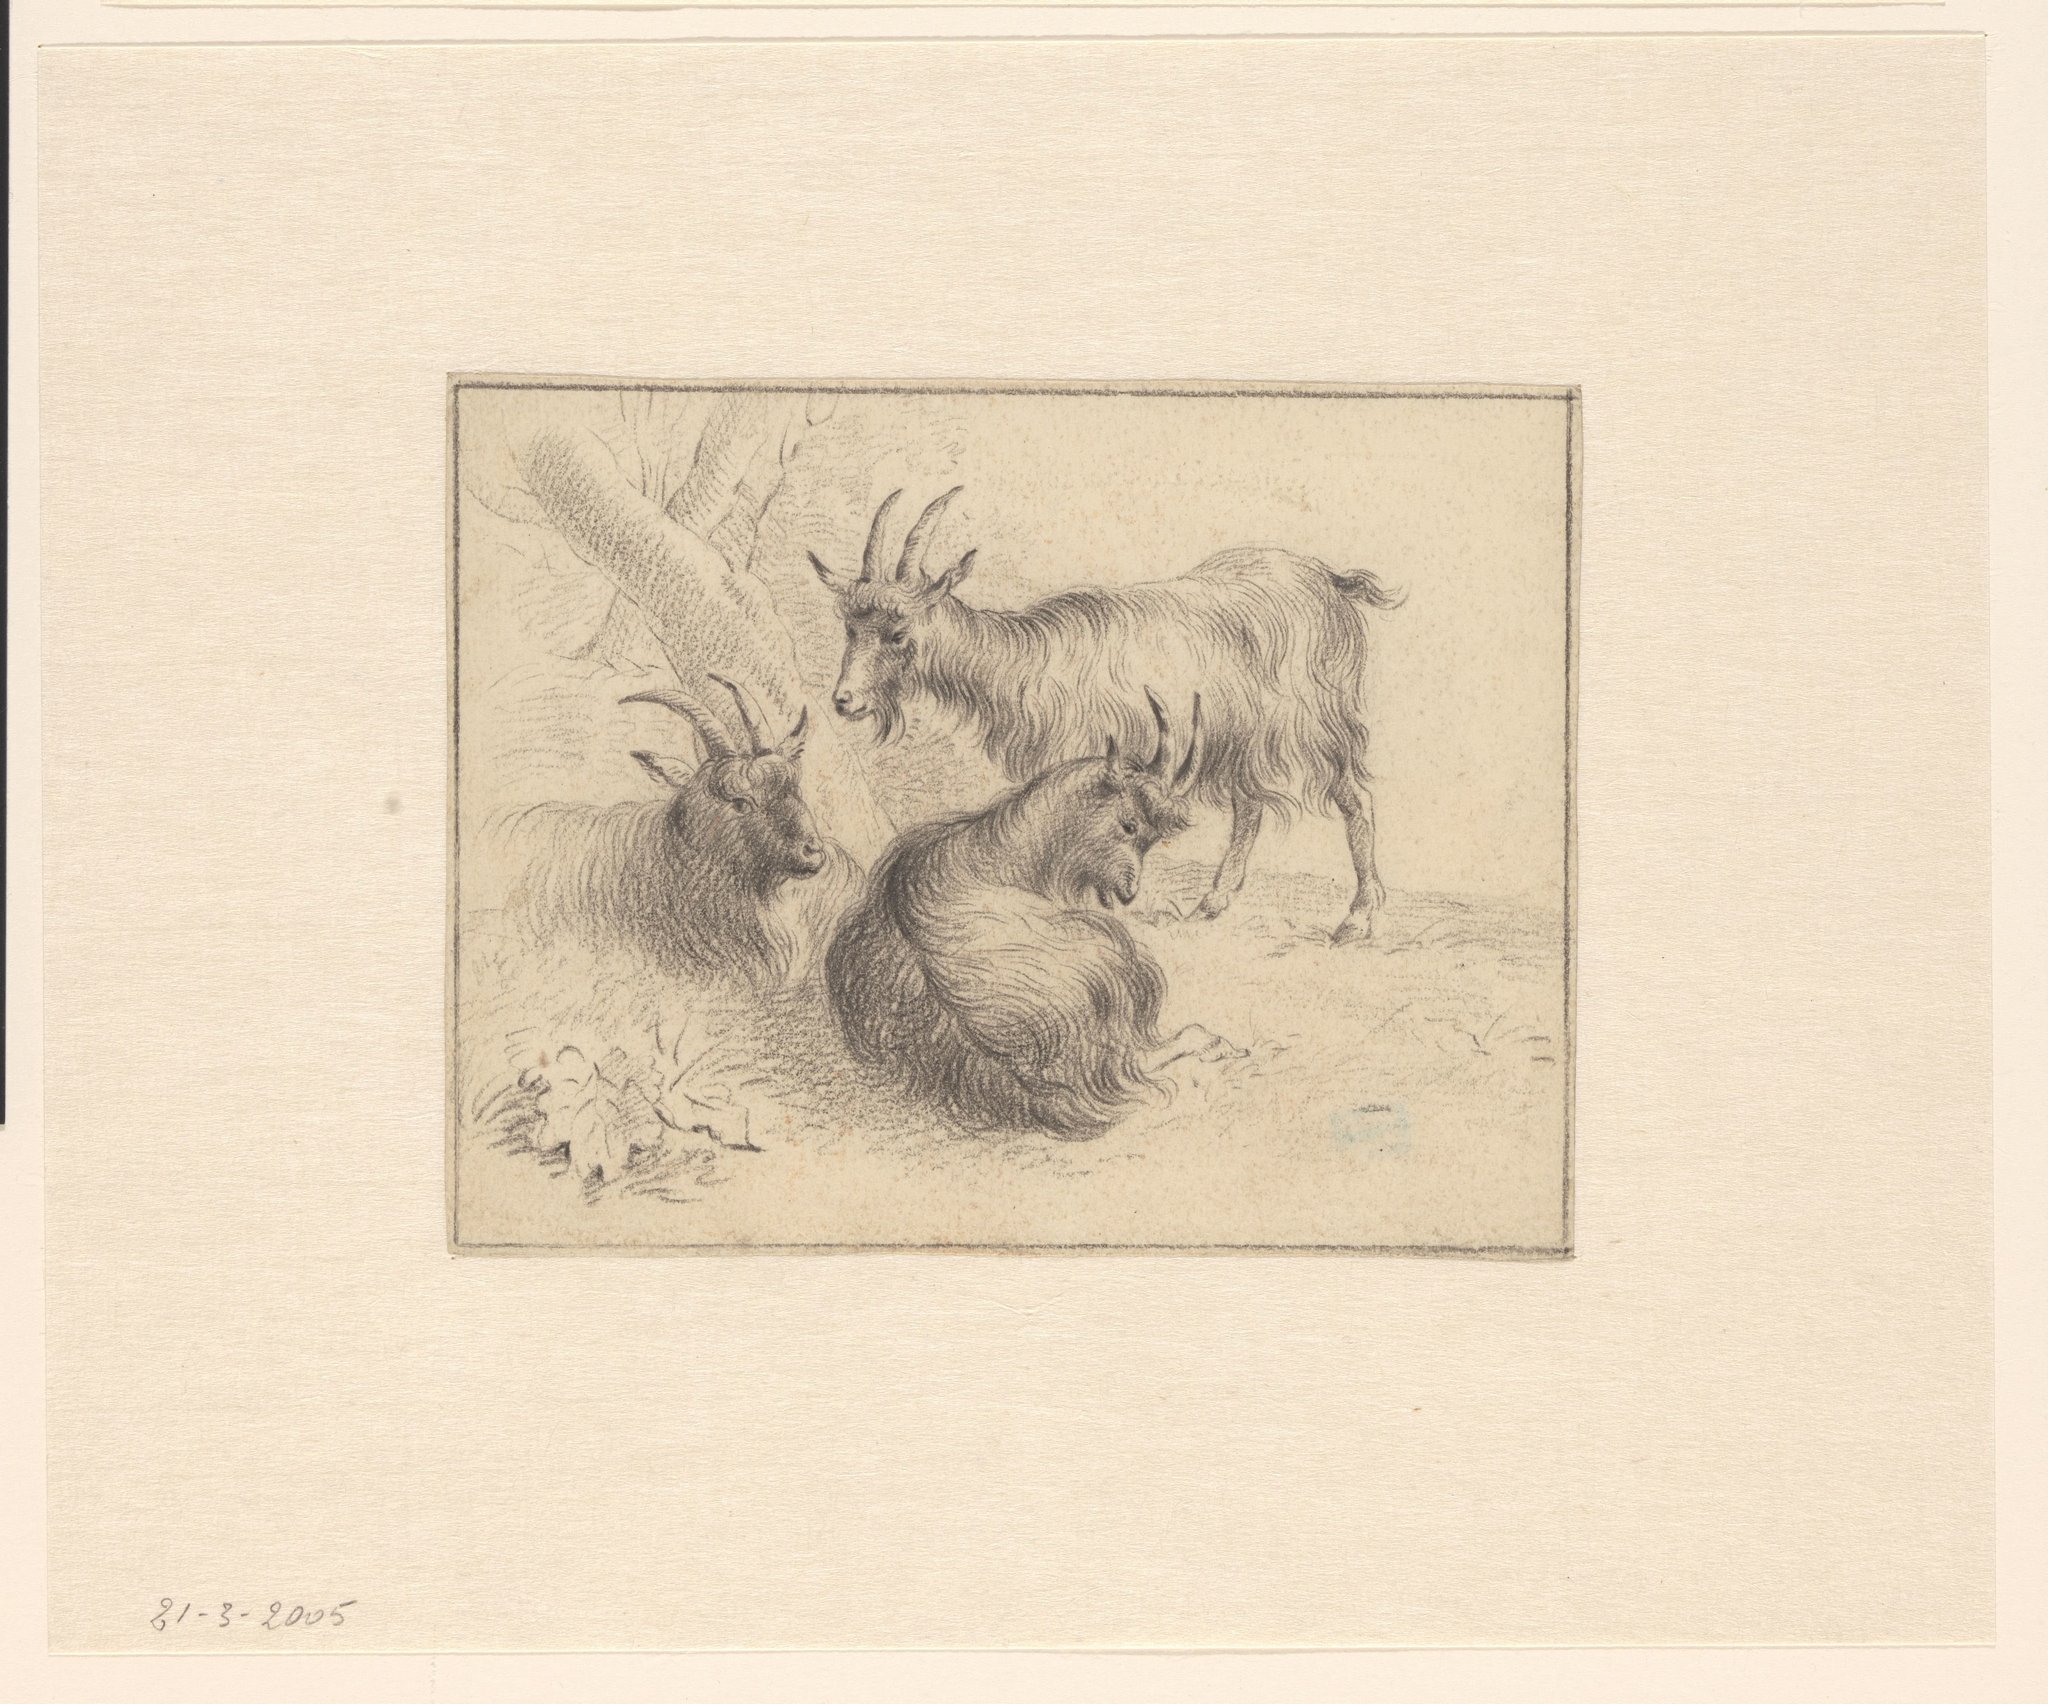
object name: drawing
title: Drie geiten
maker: Anonymous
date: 1631-1733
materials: chalk, paper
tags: goat